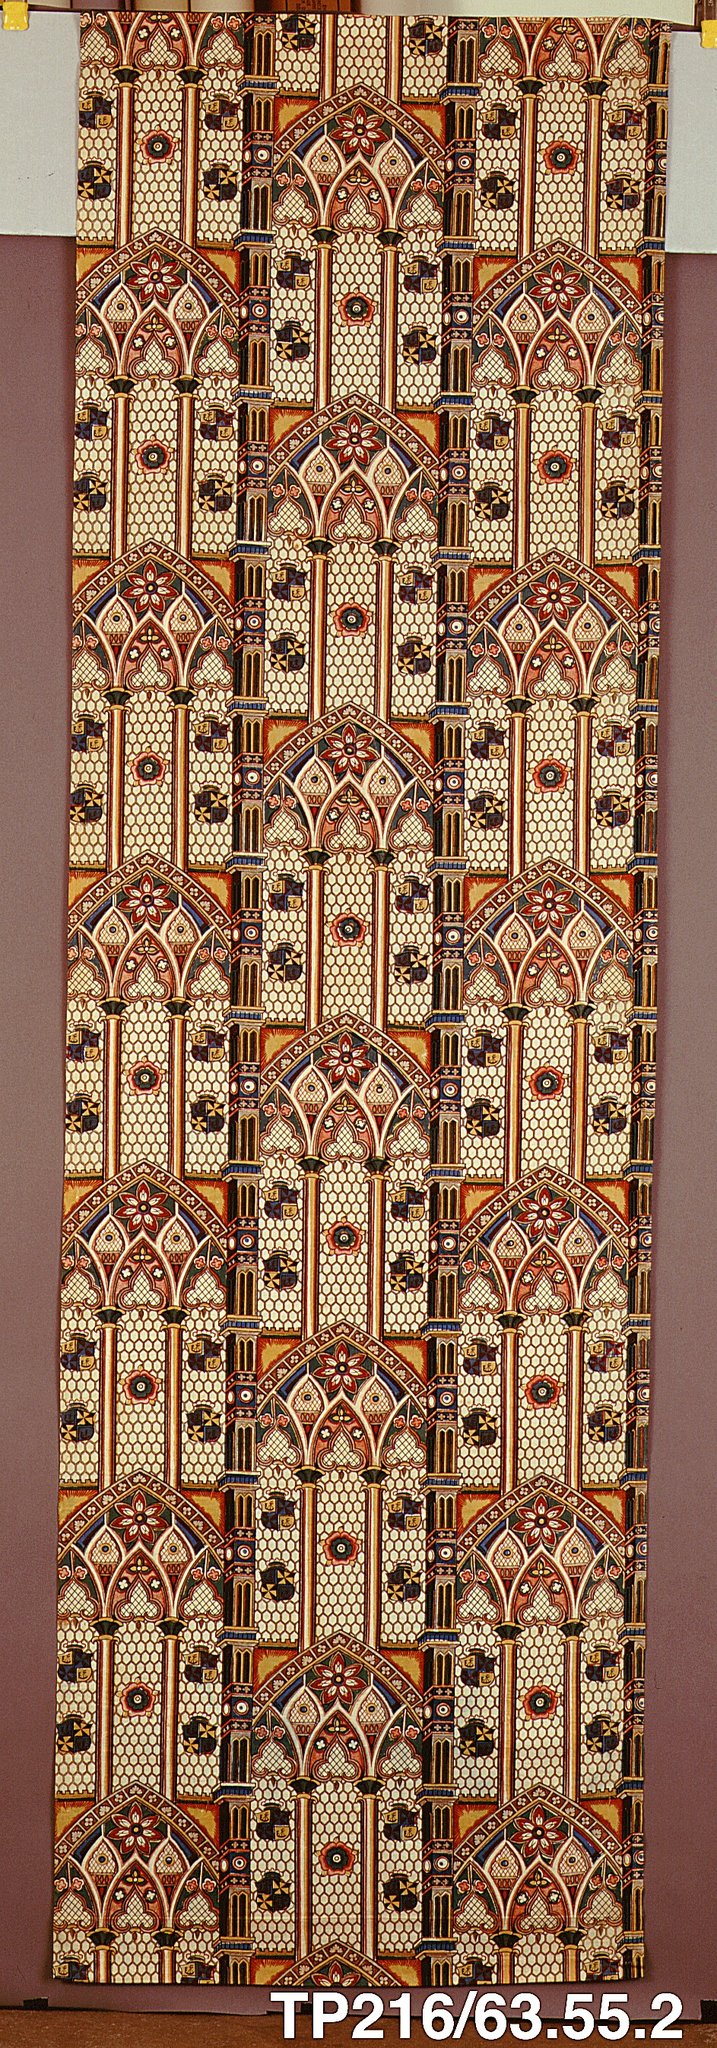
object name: piece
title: Length of roller printed cotton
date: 1830-1835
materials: cotton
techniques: glazing, printing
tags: windows,coat of arms